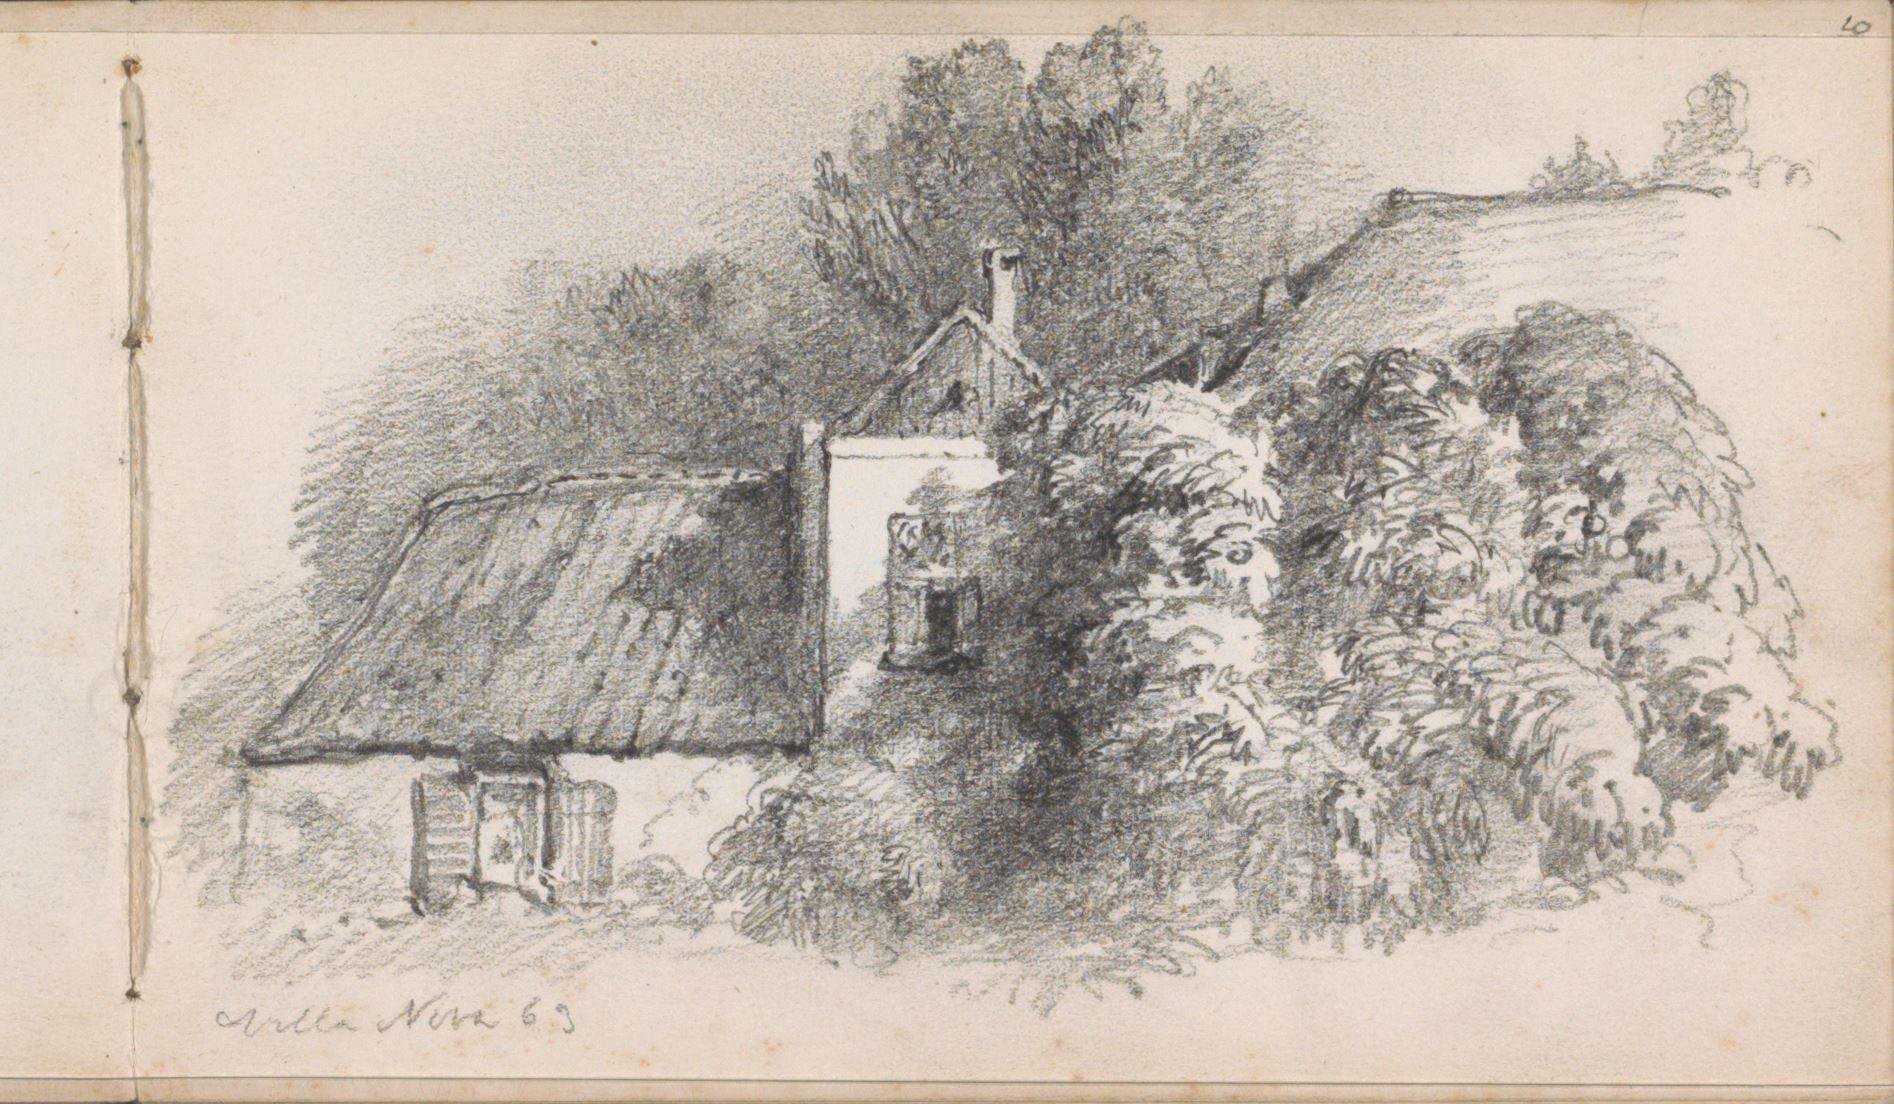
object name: sketchbook leaf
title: Villa op het platteland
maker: maria vos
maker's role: draughtsman, painter, print maker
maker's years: 1824-1906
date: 1863-1864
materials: paper, pencil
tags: rural housing, e.g. country-house, villa, cottage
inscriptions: date and inscription: ‘villa Nov 63’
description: Blad 20 recto uit een schetsboek met 41 bladen.